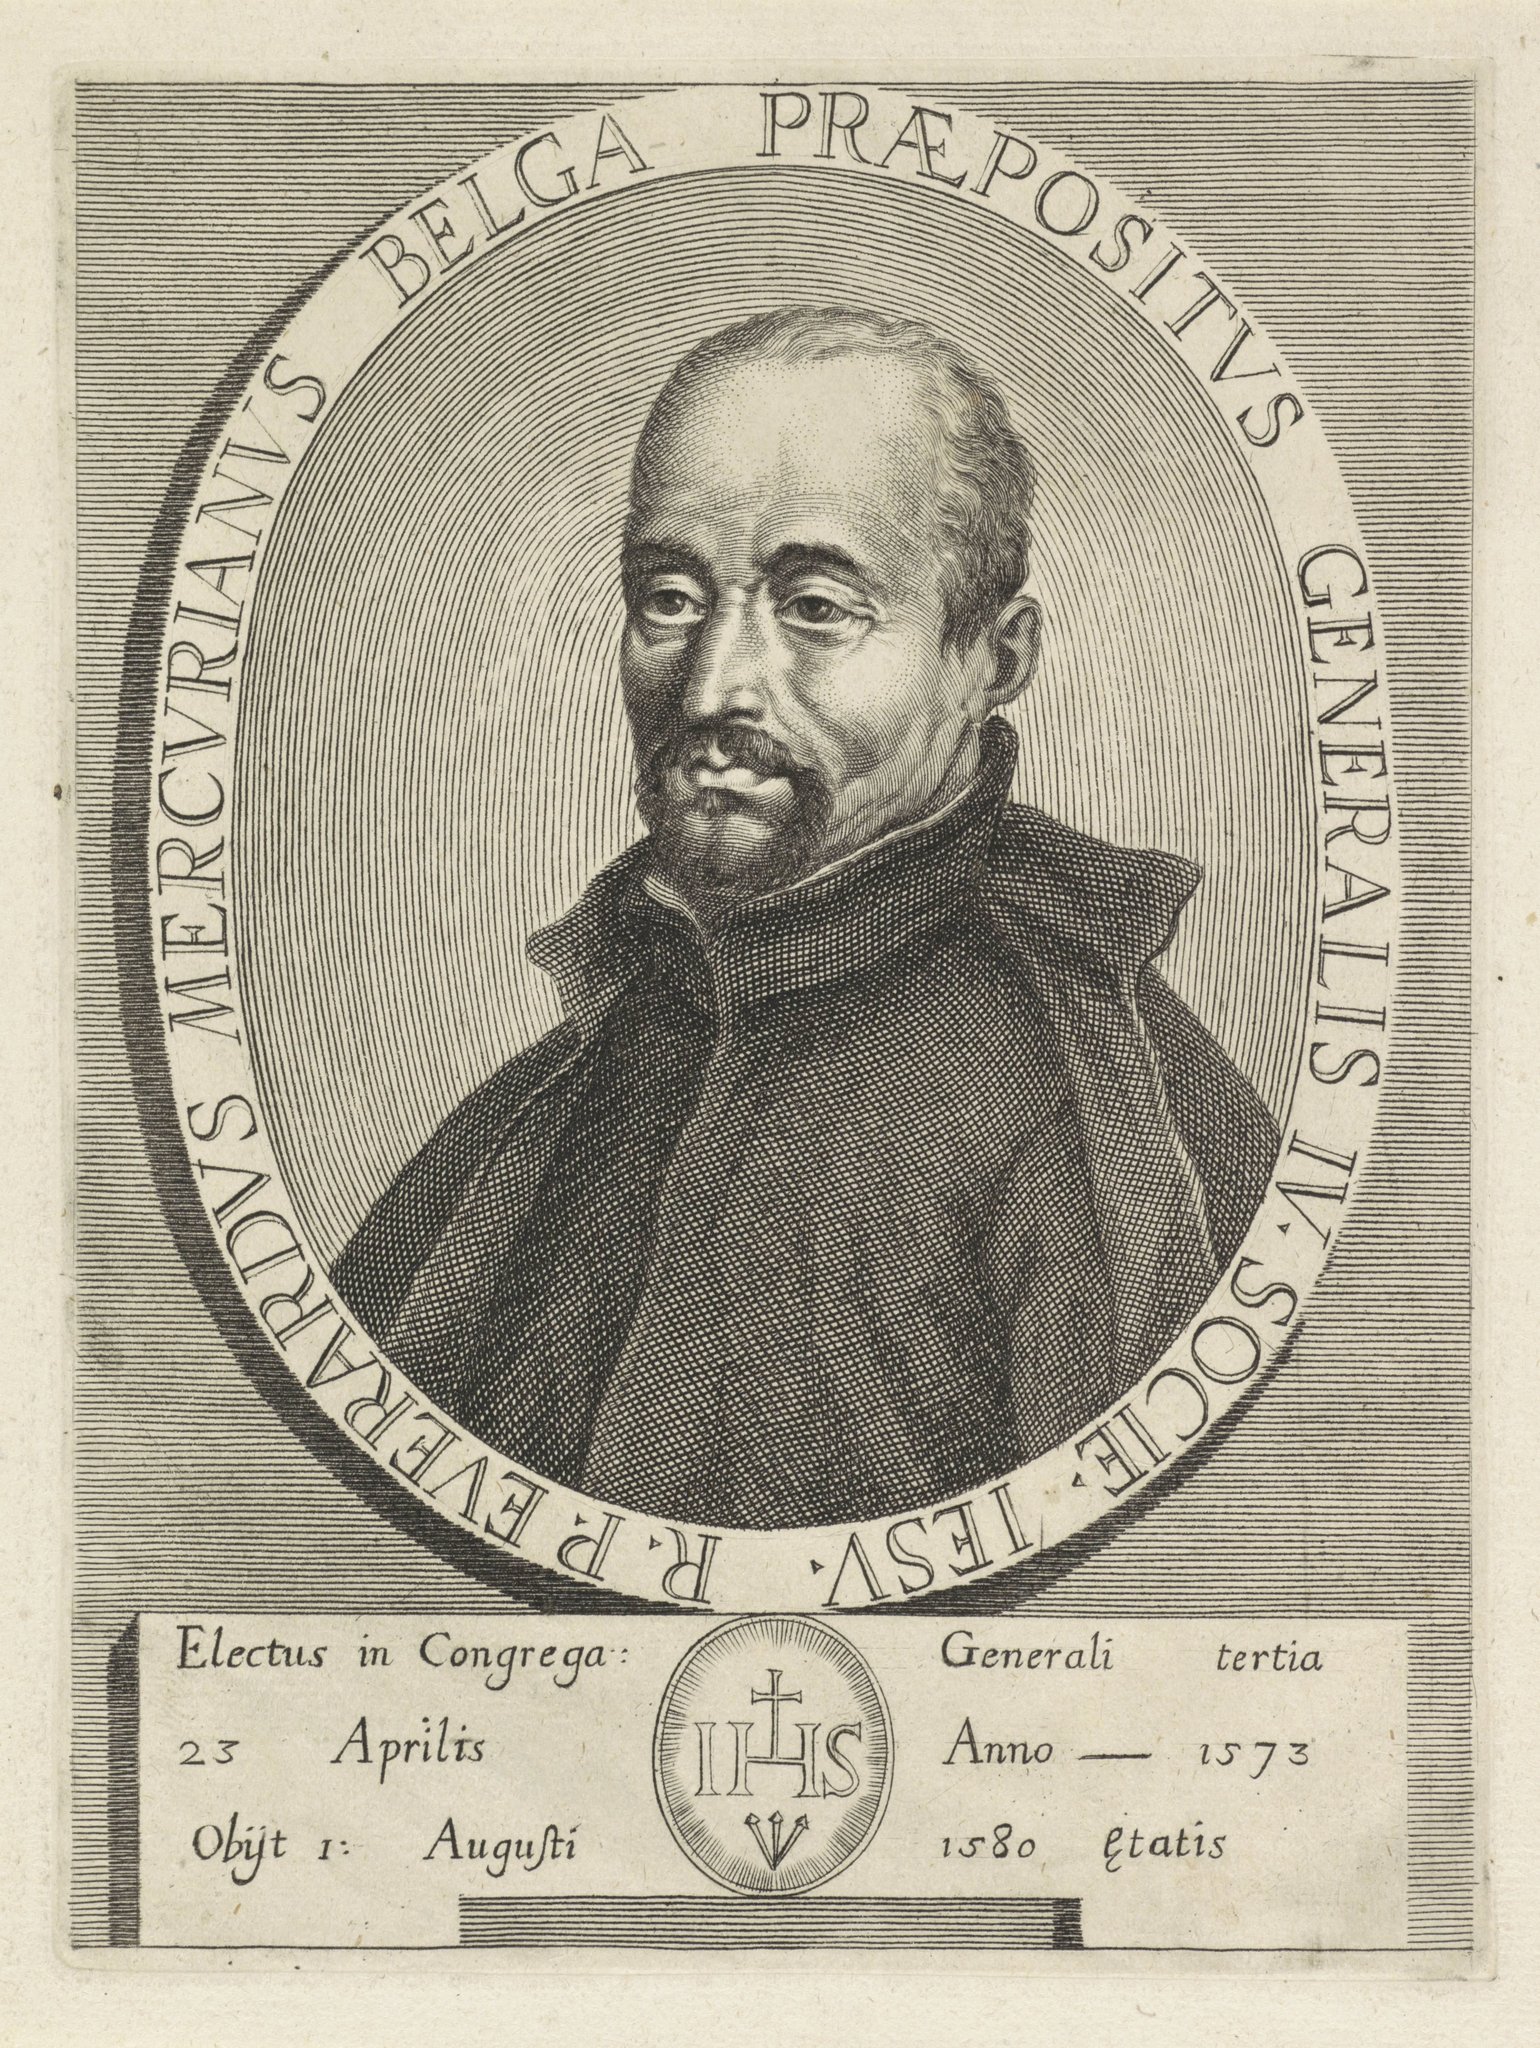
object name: print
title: Portretten van generaal oversten van de jezuïeten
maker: arnold van westerhout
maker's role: print maker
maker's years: 1651-1725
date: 1731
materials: paper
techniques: engraving, etching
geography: italy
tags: rome, ihs ('iesus hominum salvator') ~ symbol of christ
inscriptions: collector's mark: Lugt 2228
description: In het kader onder zijn portret het monogram van de jezuïeten.